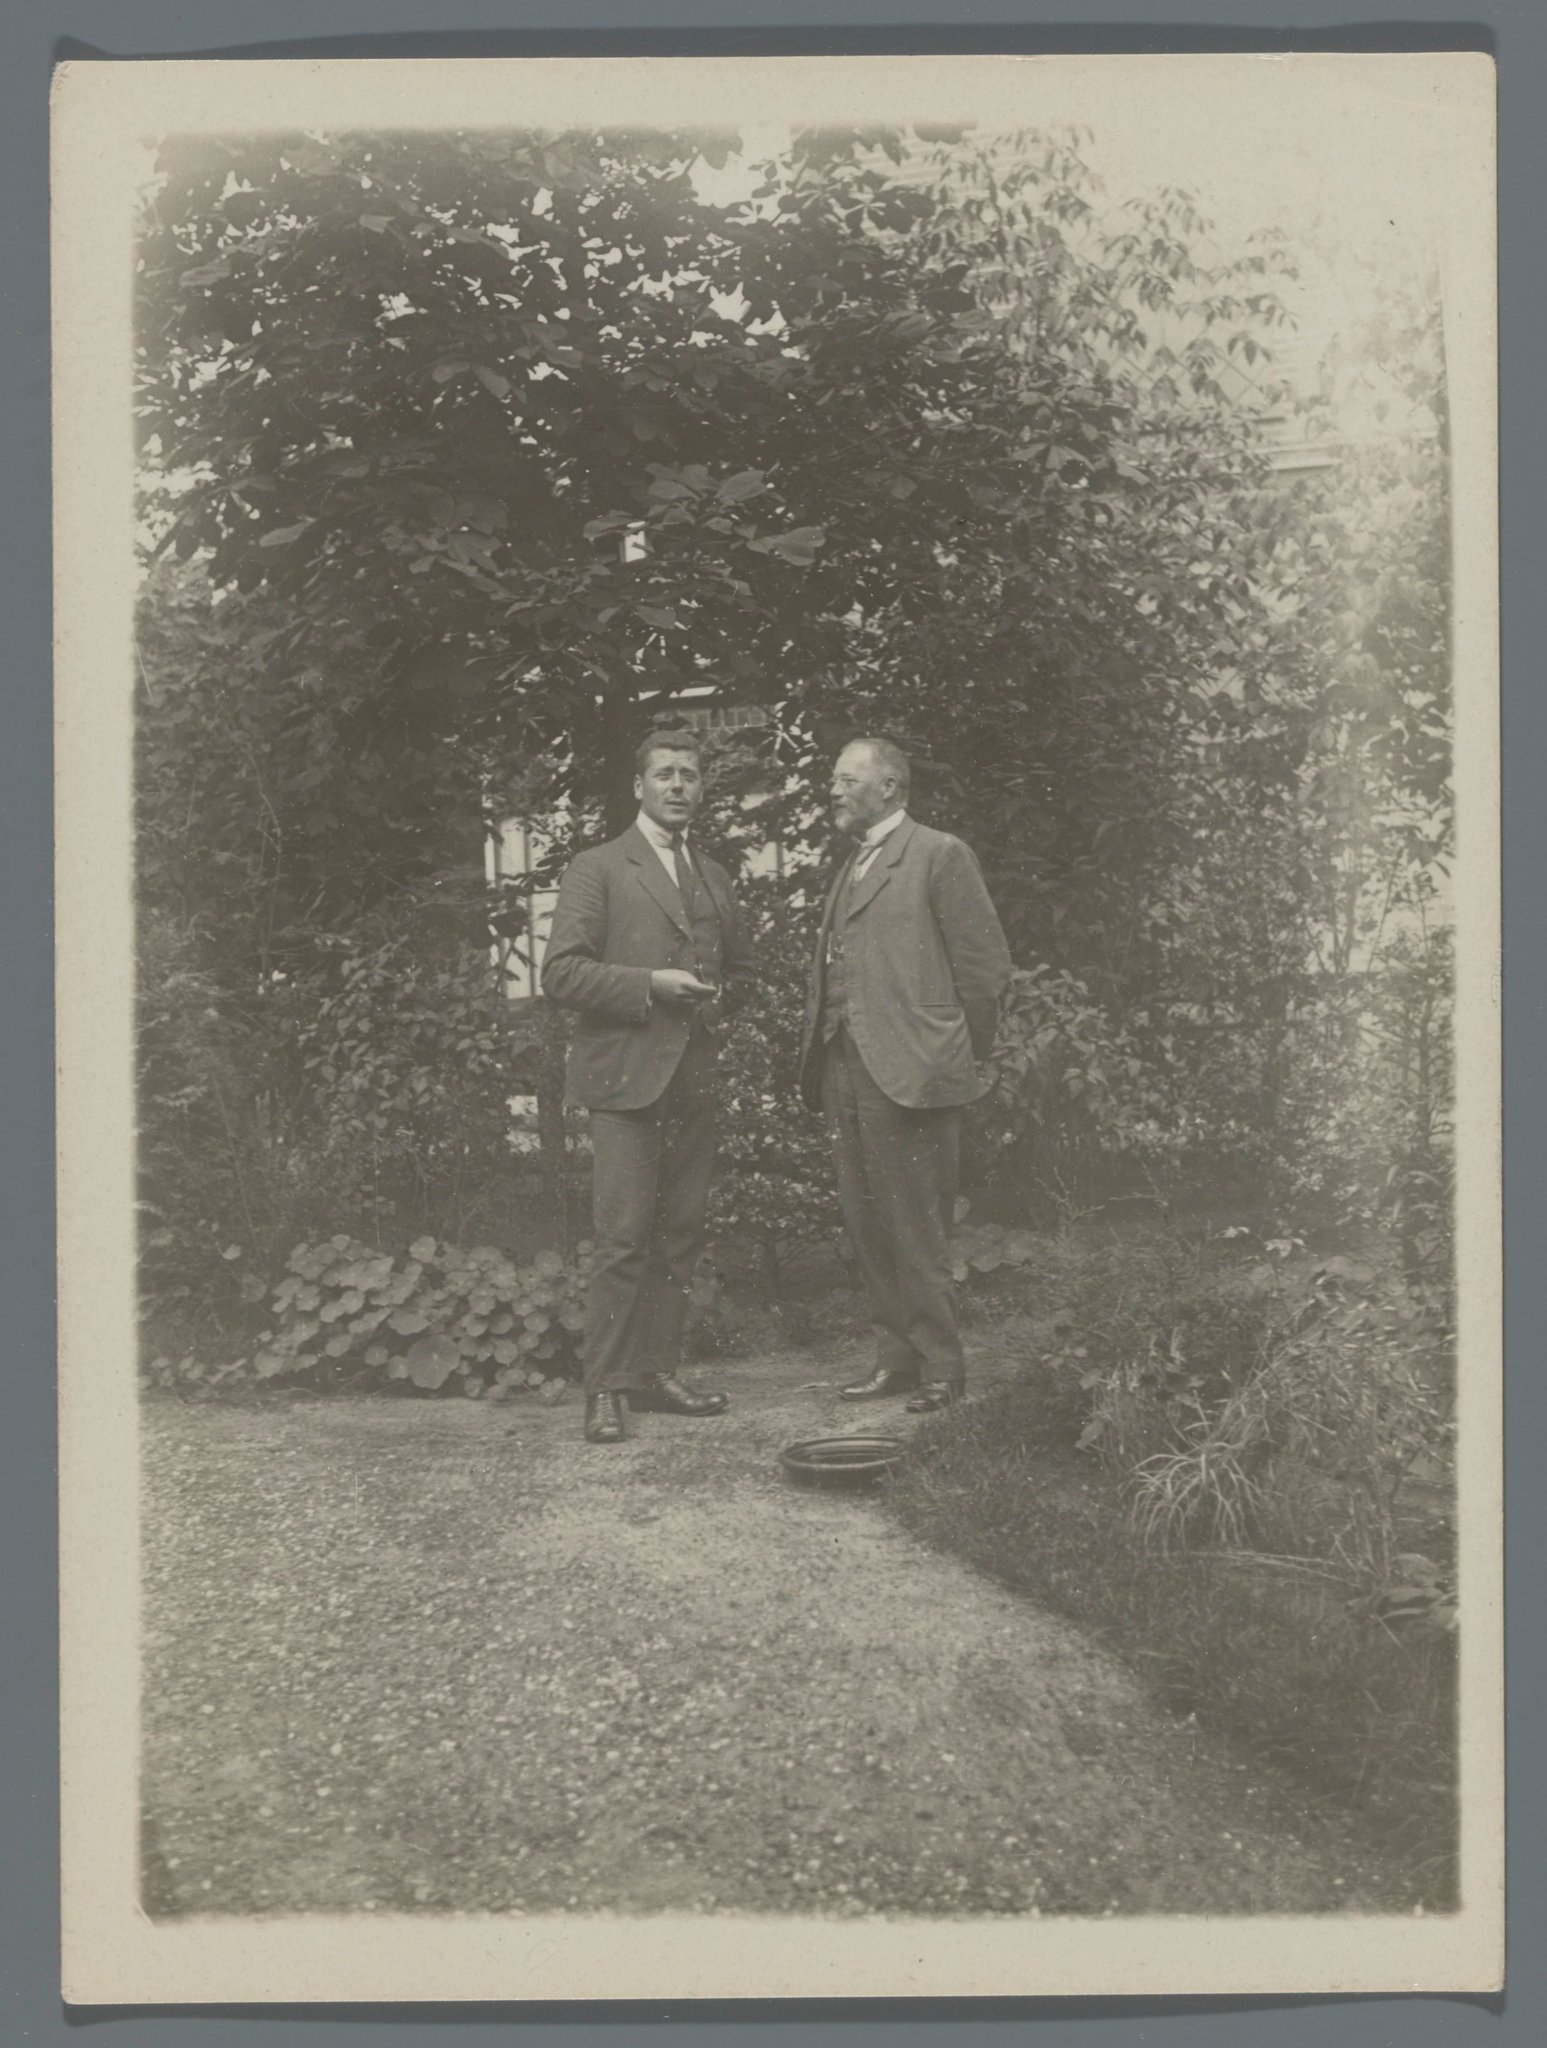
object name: photograph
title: Portret van twee onbekende mannen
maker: cornelia hendrika jonker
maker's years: 1874-1924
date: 1910-1950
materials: photographic support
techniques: gelatin silver print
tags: garden, historical persons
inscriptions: annotation: ‘Vader Langhout/ Grootvader Jonker’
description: Annotatie op verso Vader Langhout/ Grootvader Jonker